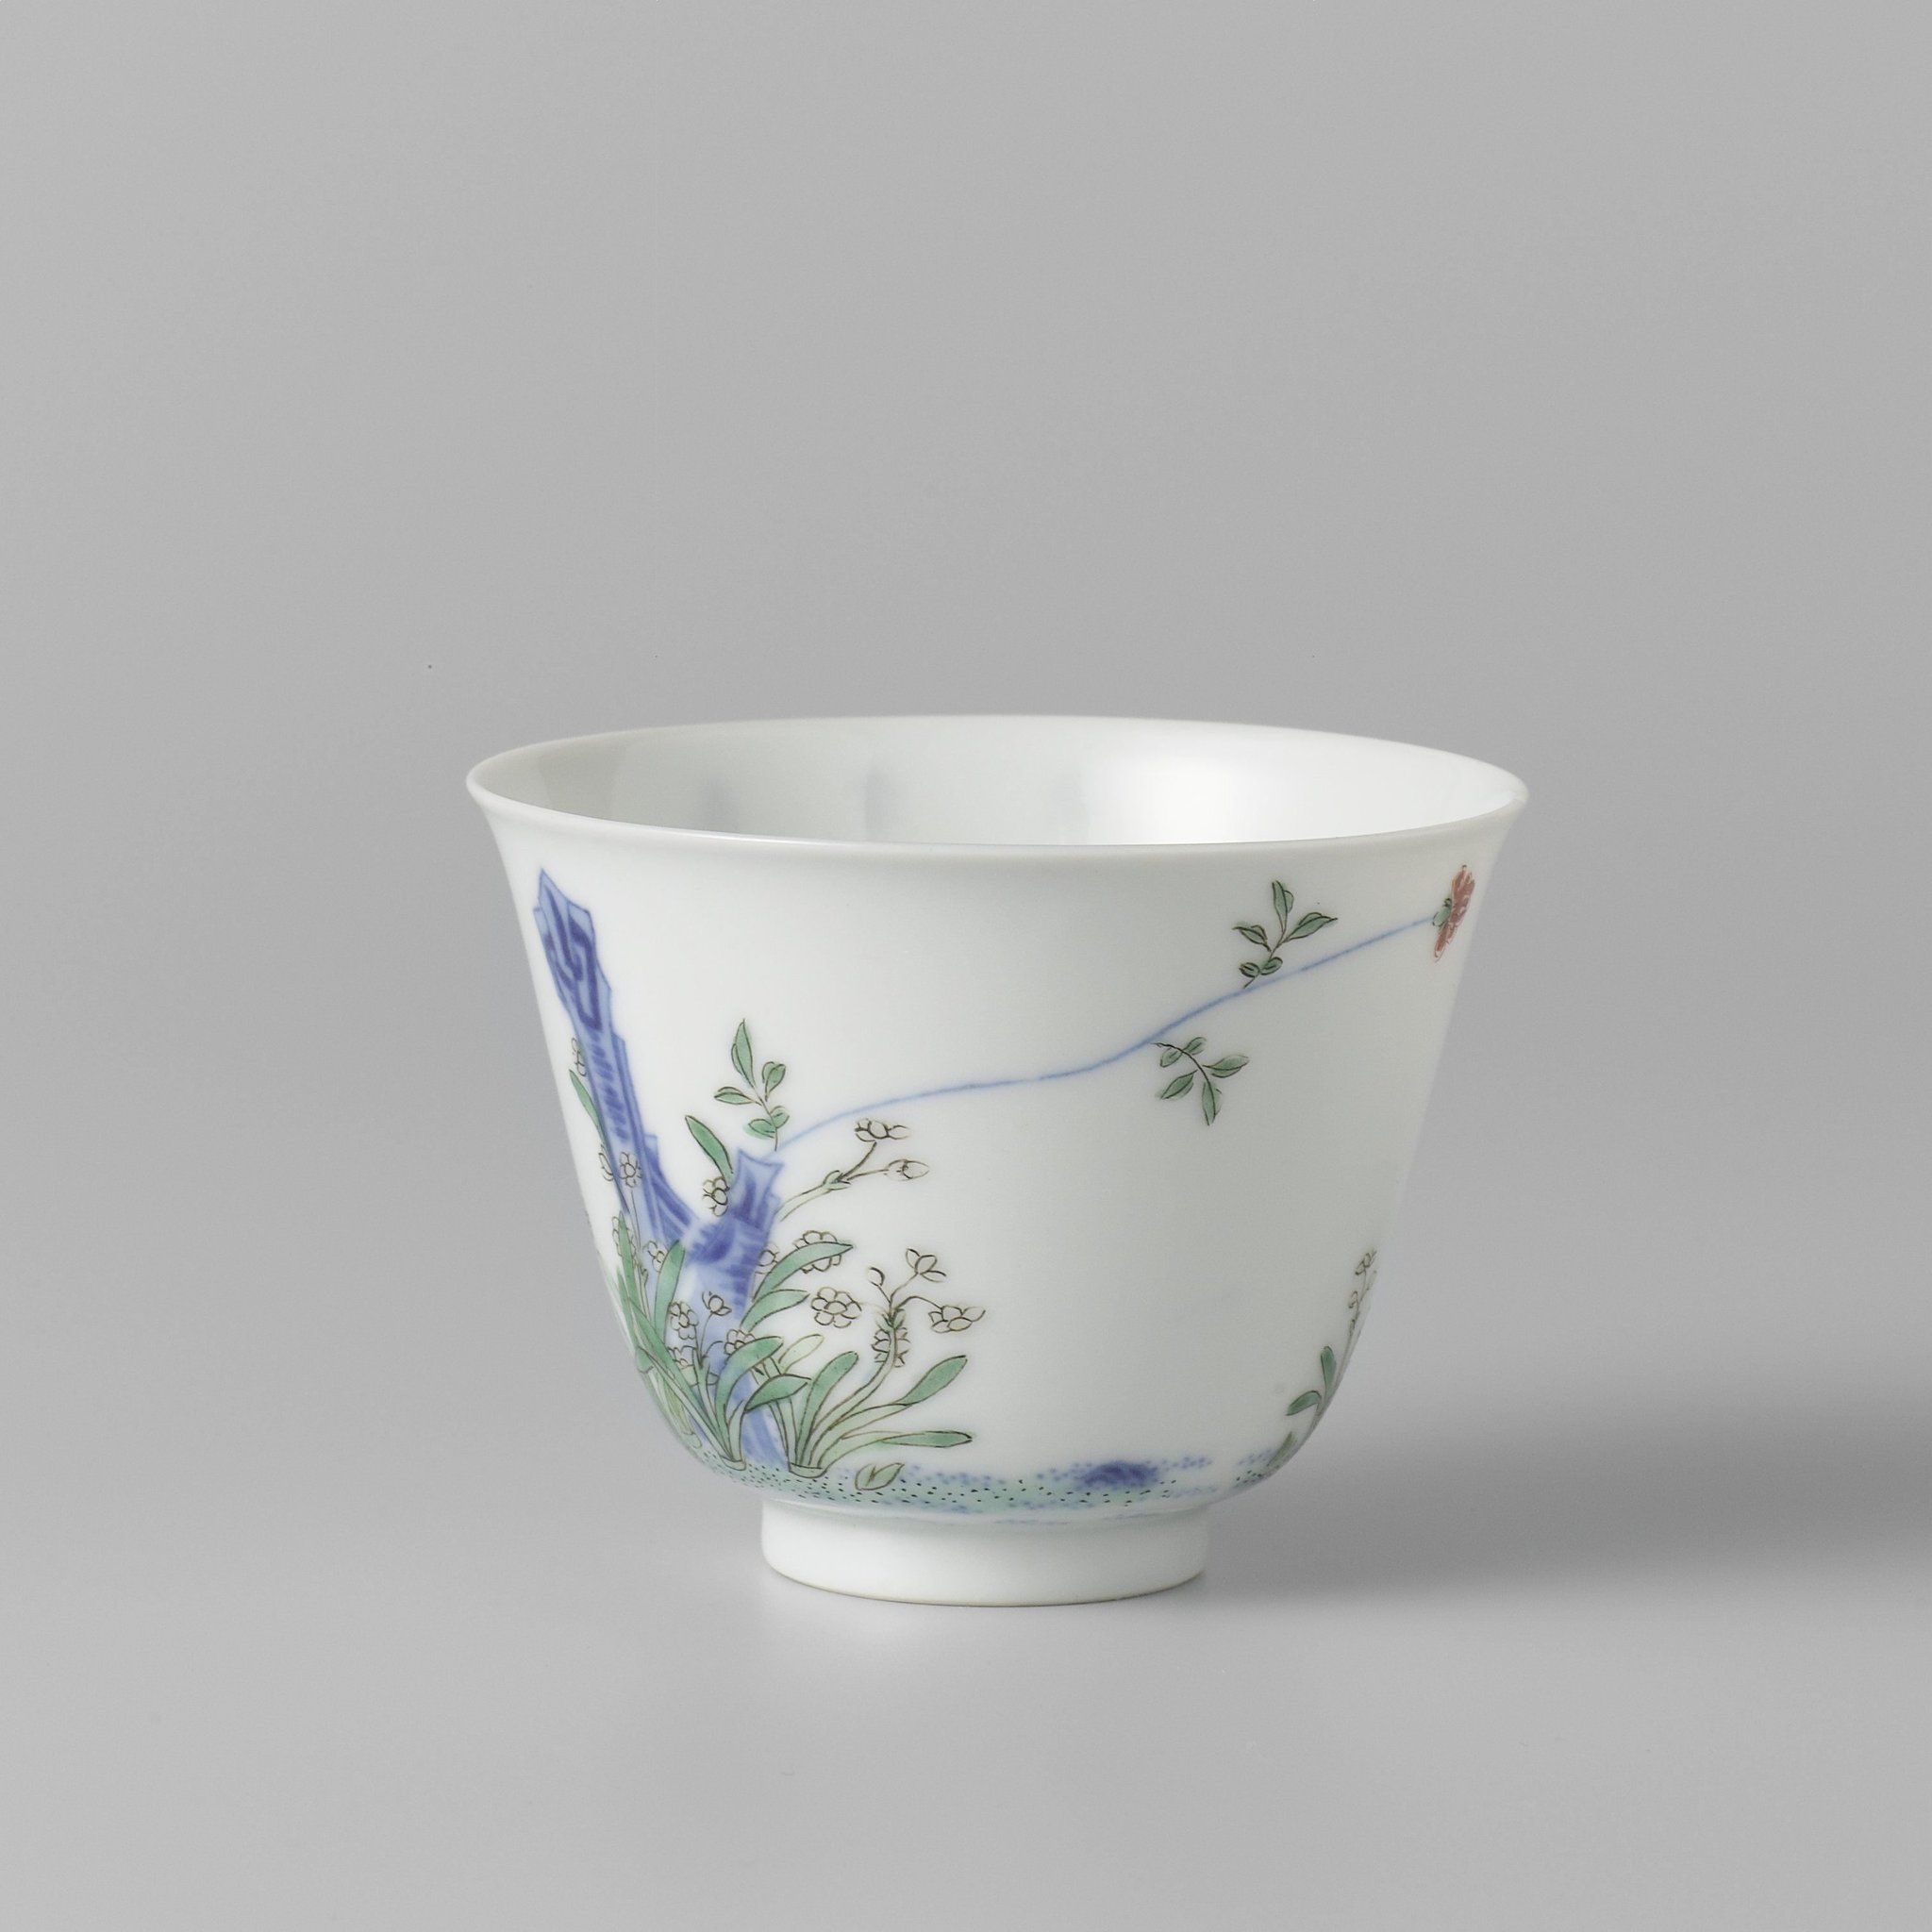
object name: cup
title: Month cup of the eleventh month with a narcissus and a poem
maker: Anonymous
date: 1700-1724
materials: cobalt, glaze, paint, porcelain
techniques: firing, turning, vitrification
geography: china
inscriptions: mark: ‘大 清 康 熙 年 製’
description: Klokvormige kop van porselein, beschilderd in onderglazuur blauw en op het glazuur blauw, rood, groen, geel en zwart. Maandkopje van de elfde maand met op de buitenwand een narcis en een tweeregelig gedicht afgesloten door het zegelmerk 'shang', waardering. Gemerkt op de onderzijde met het zes-karaktermerk van keizer Kangxi in een dubbele cirkel. Porselein met emailkleuren.